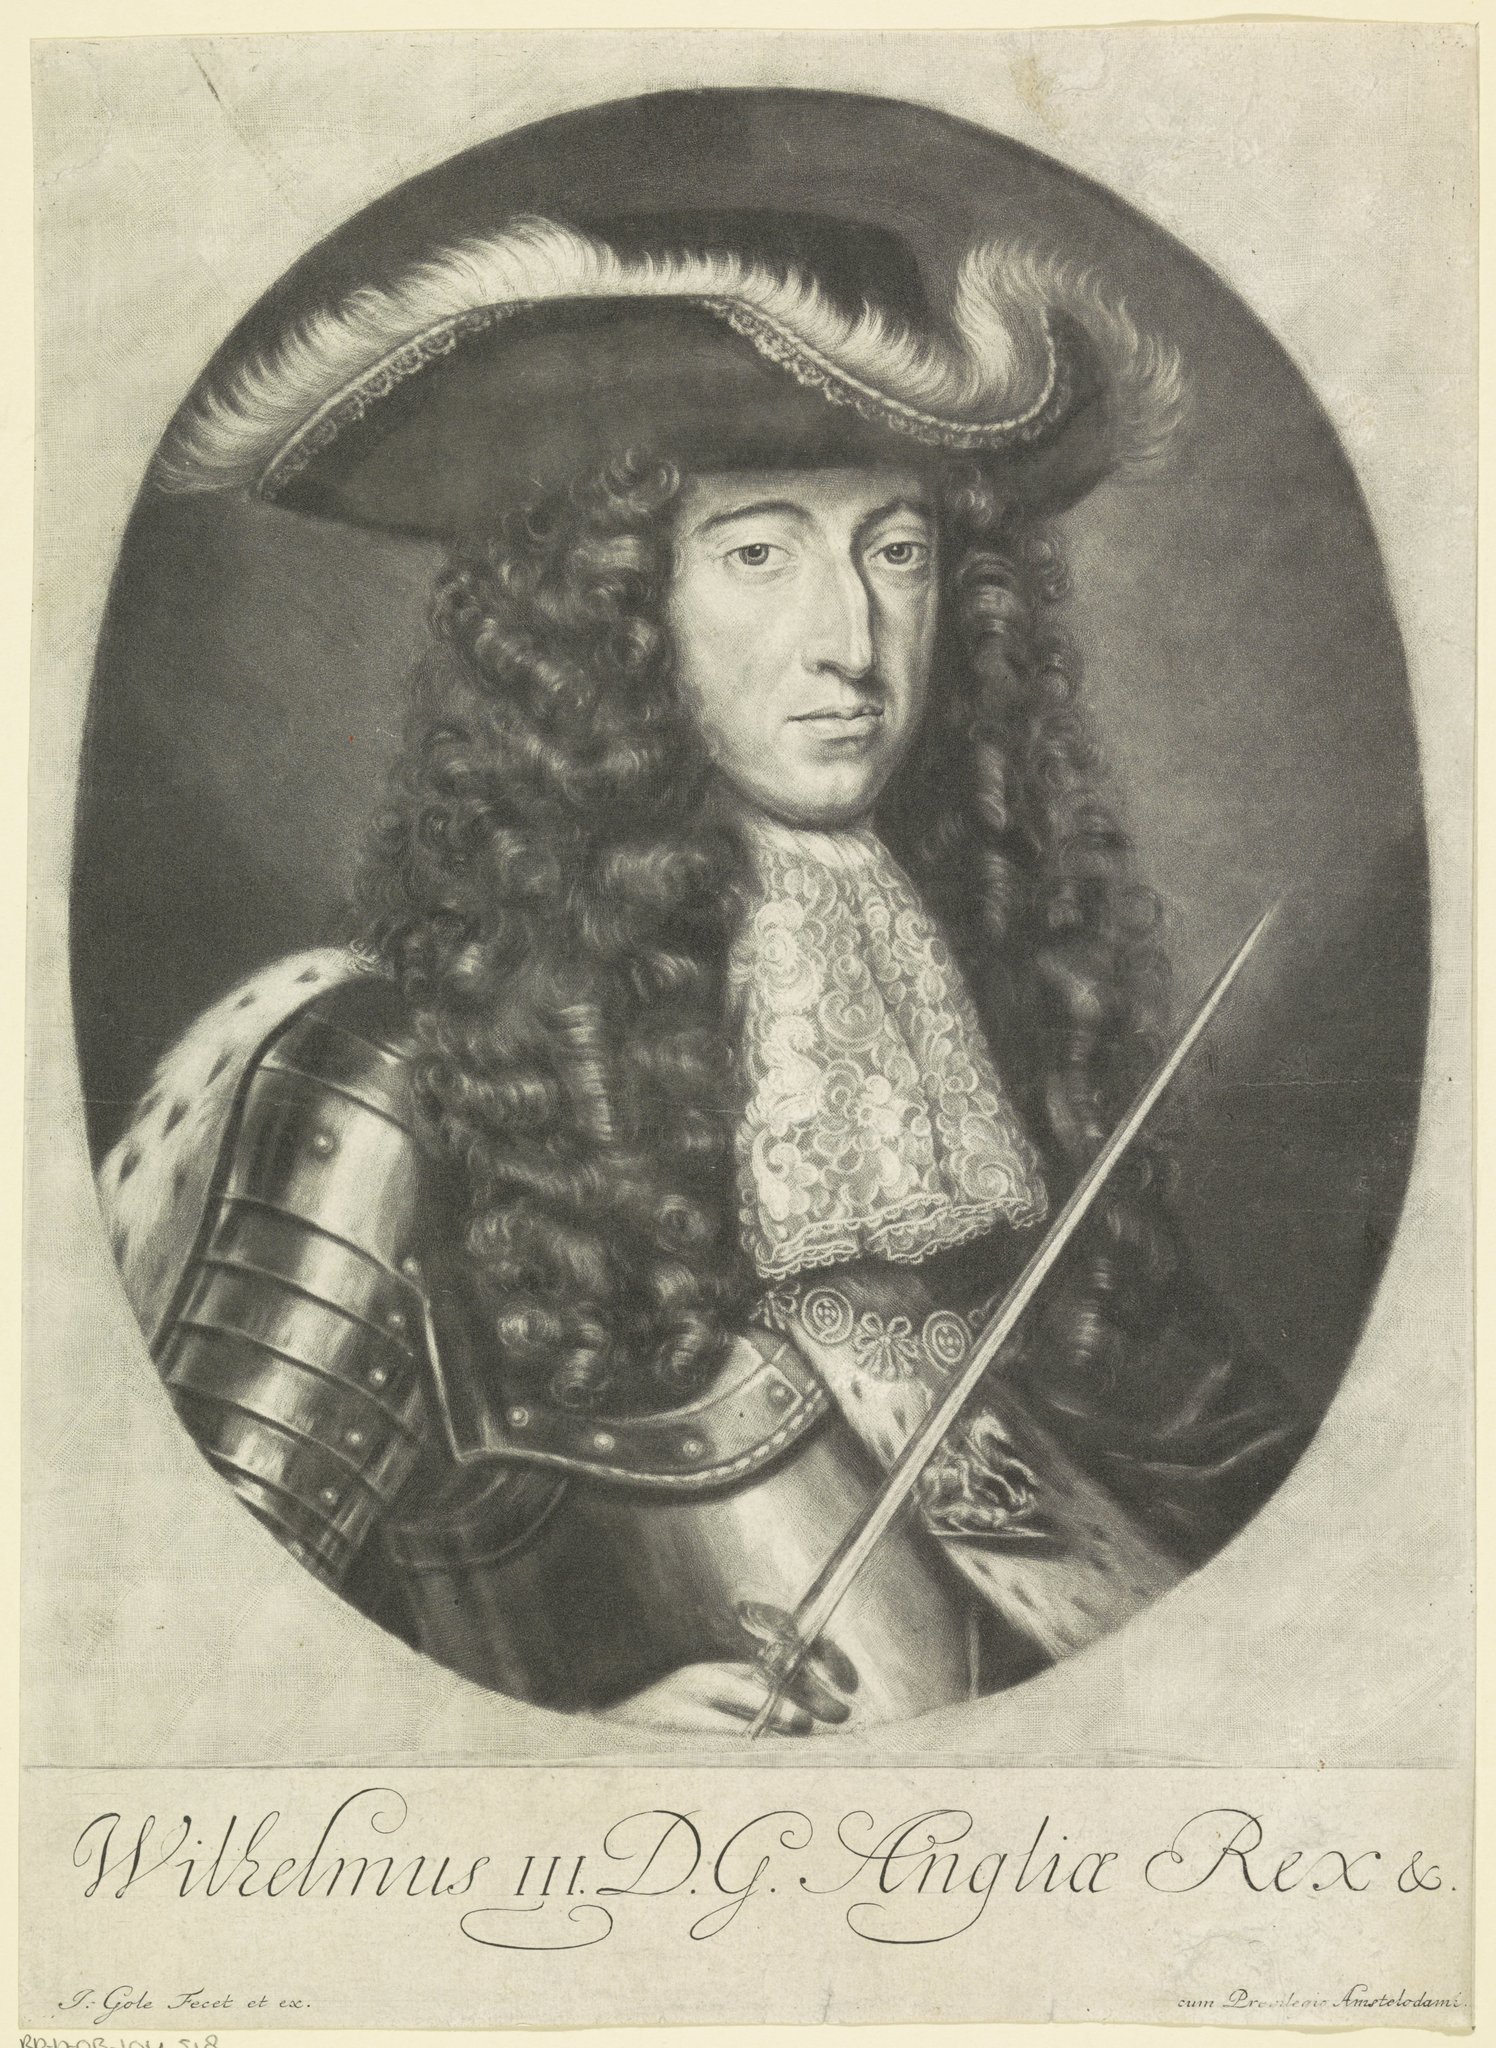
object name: print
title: Portret van Willem III, prins van Oranje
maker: jacob gole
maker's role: print maker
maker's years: 1660-1724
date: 1688-1724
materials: paper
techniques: mezzotint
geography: amsterdam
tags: the hague, william iii (prince of orange and king of england, scotland, and ireland), knighthood order (garter) - insignia of a knighthood order, e.g.: badge, chain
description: De hier vermelde titel verwijst naar de hoogst verkregen titel van de geportretteerde, niet per se naar de titel die de geportretteerde op deze voorstelling draagt.